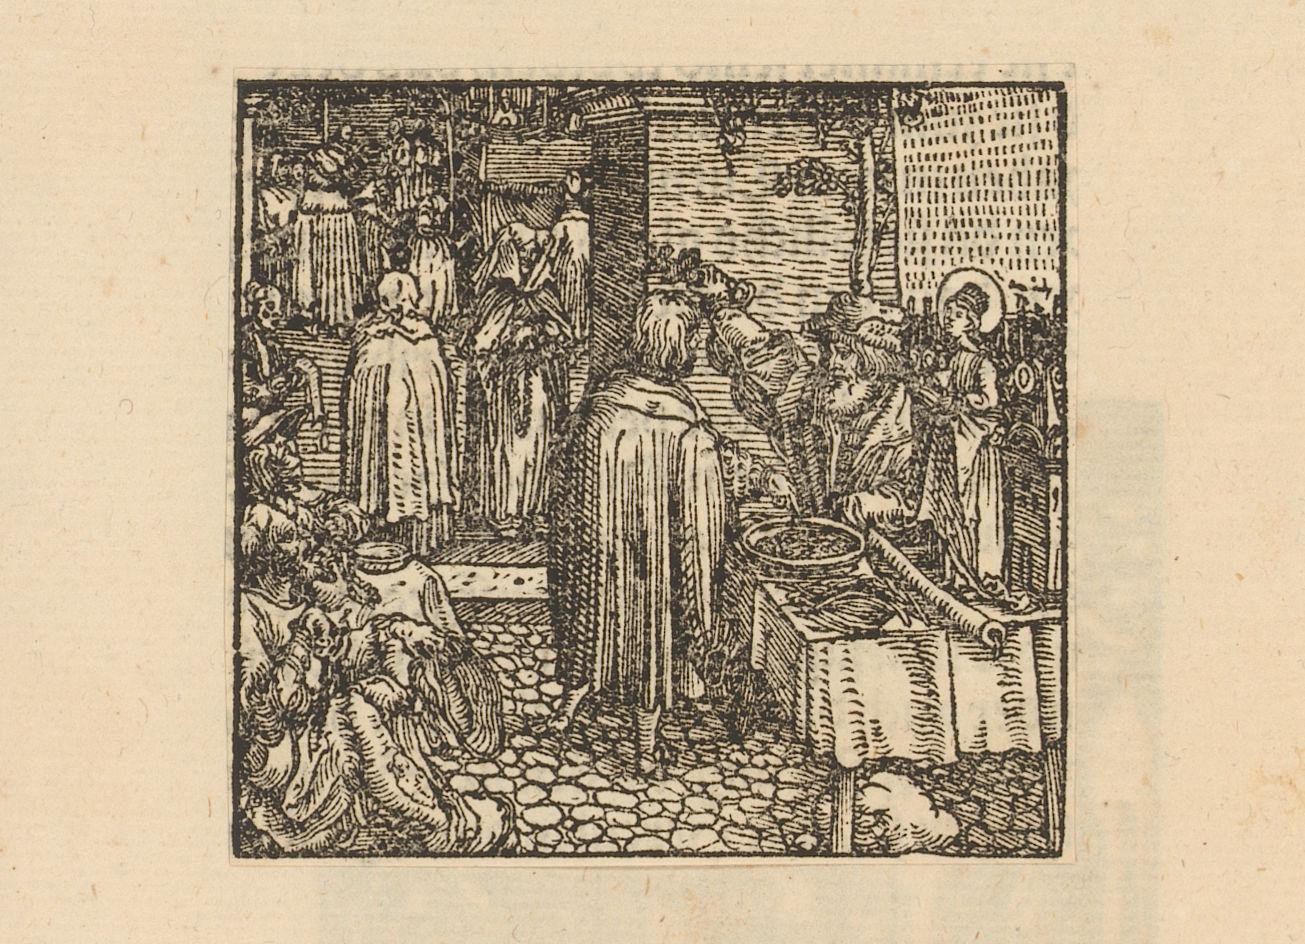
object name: book illustration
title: Menigte bij de ingang van een kerk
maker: Anonymous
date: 1514-1532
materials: paper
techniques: letterpress printing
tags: roman catholic church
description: Deze prent is gebruikt in: Petrarca, Francesco. Von der Artzney bayder Glück, des guten und widerwertigen: unnd weß sich ain yeder inn Gelück und Unglück halten sol (...). Augsburg: Heinrich Steiner, 1532. Deze uitgave is ook bekend onder de titel 'Trostspiegel in Glück und Unglück'.